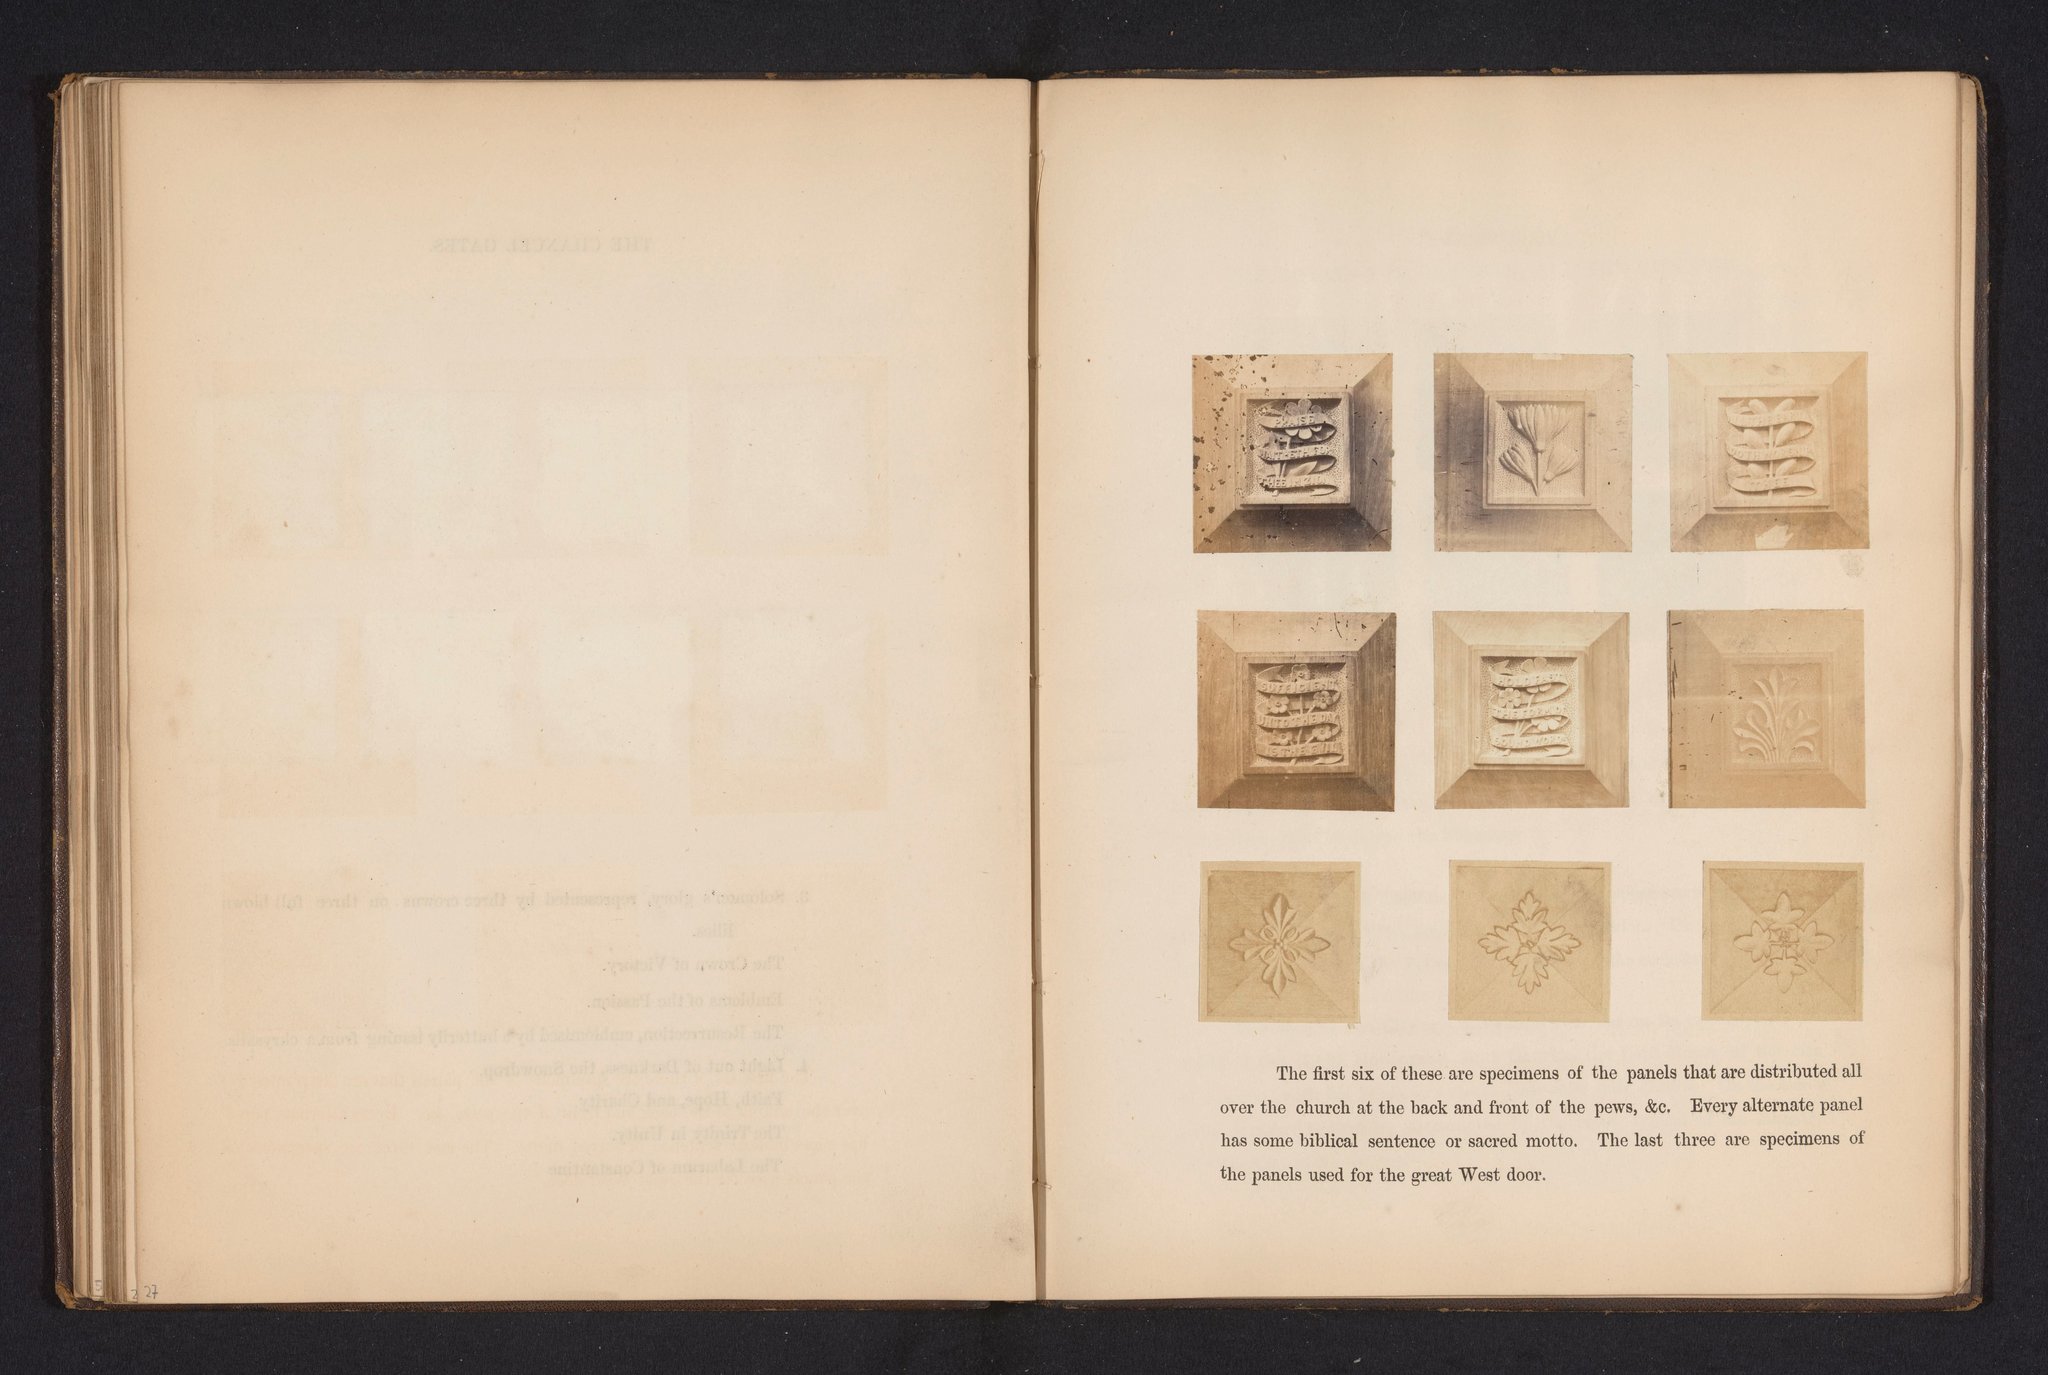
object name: page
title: Negen decoraties uit de St Michael in Cornhill, voorstellend plant en bloemmotieven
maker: Anonymous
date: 1857-1867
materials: photographic support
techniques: albumen print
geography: st michael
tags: gate, entrance, flowers ~ ornament